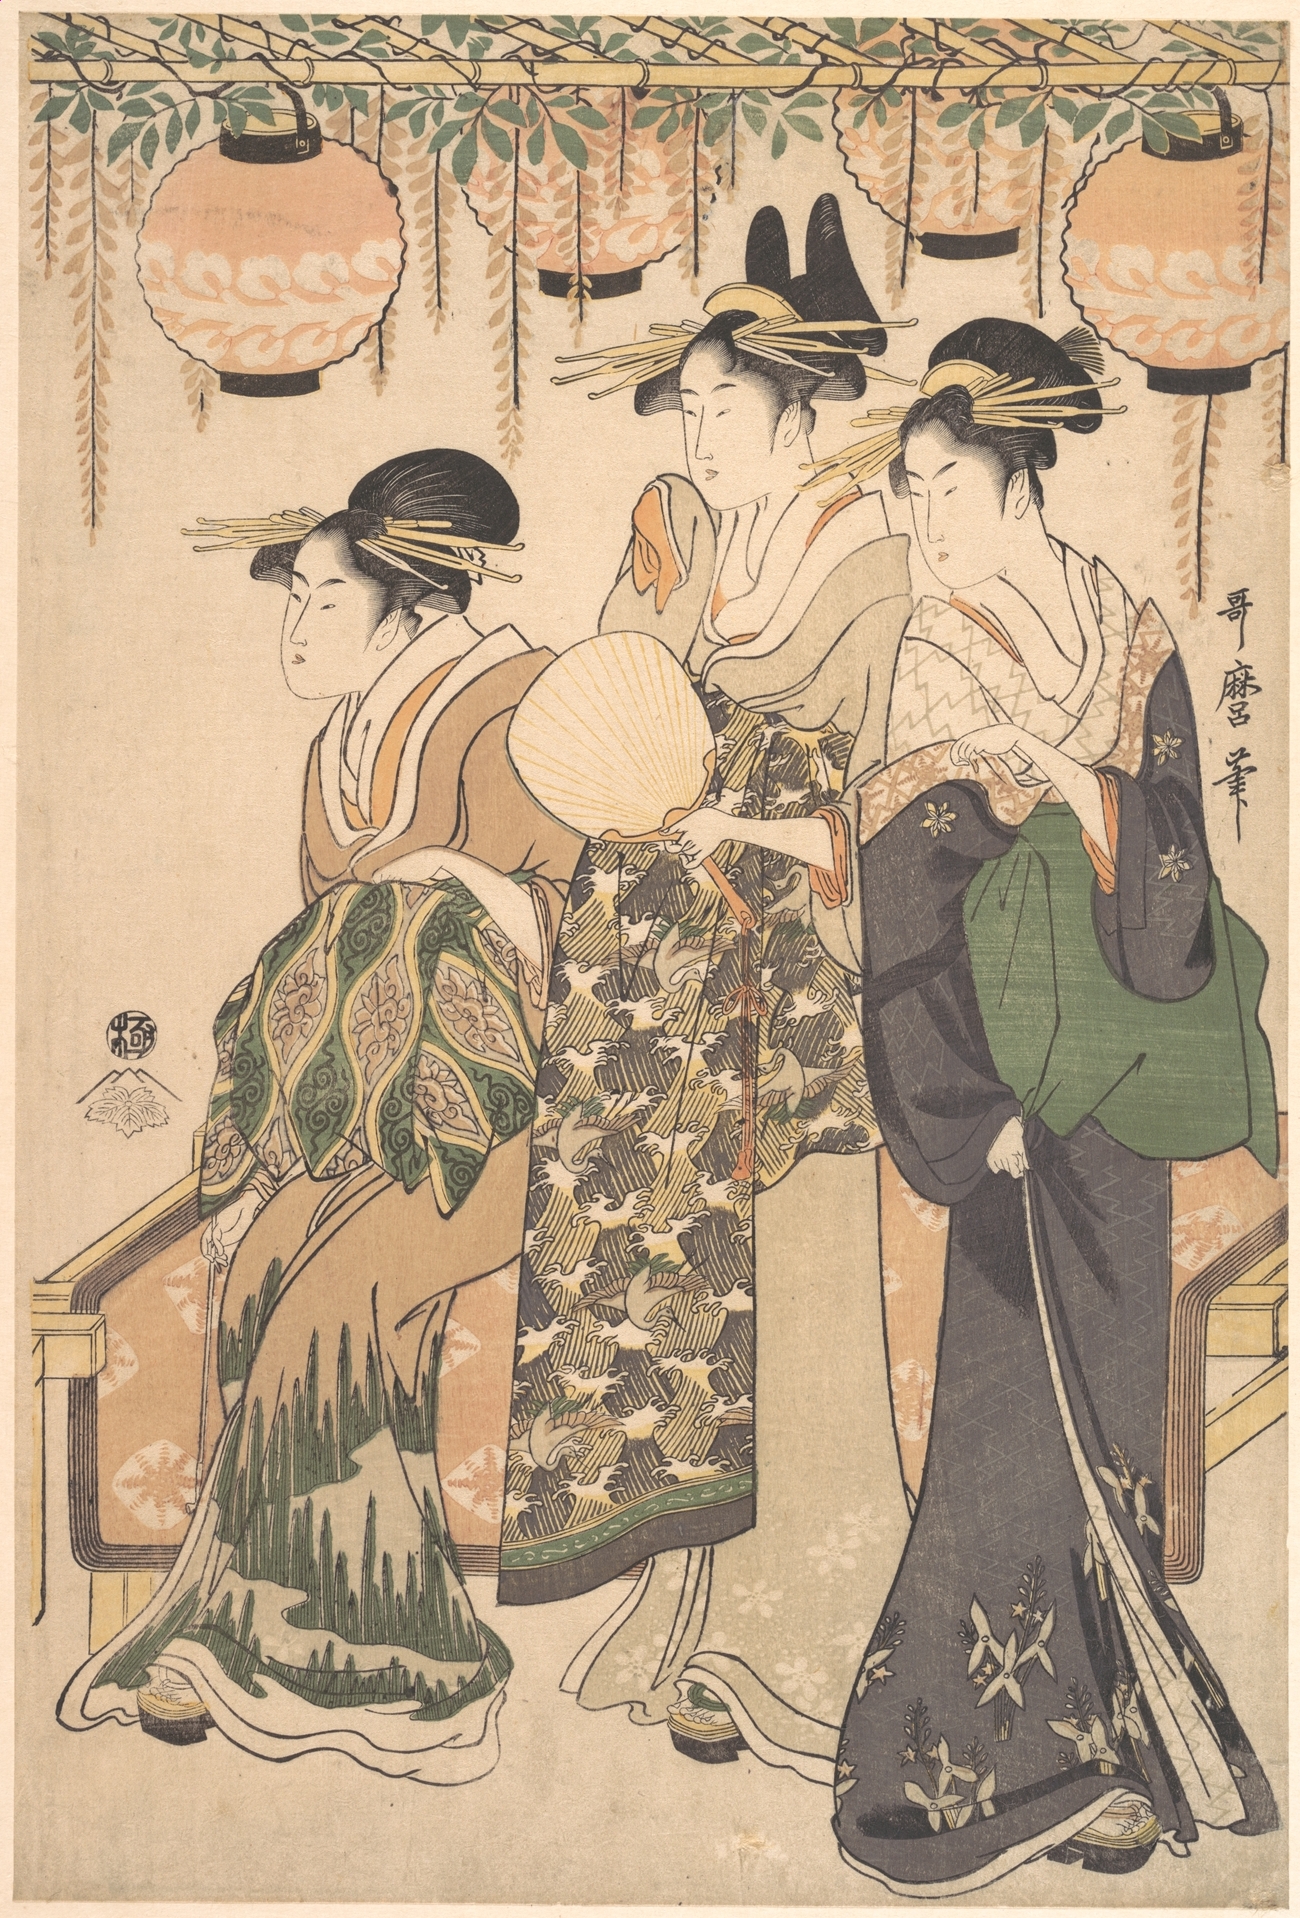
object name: print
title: Courtesans Beneath a Wisteria Arbor (Fuji dana shita no yūjo tachi)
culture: japanese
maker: kitagawa utamaro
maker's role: artist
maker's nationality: japanese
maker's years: 1754-1806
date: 1795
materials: ink, paper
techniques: woodblock print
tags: fans,women,leaves